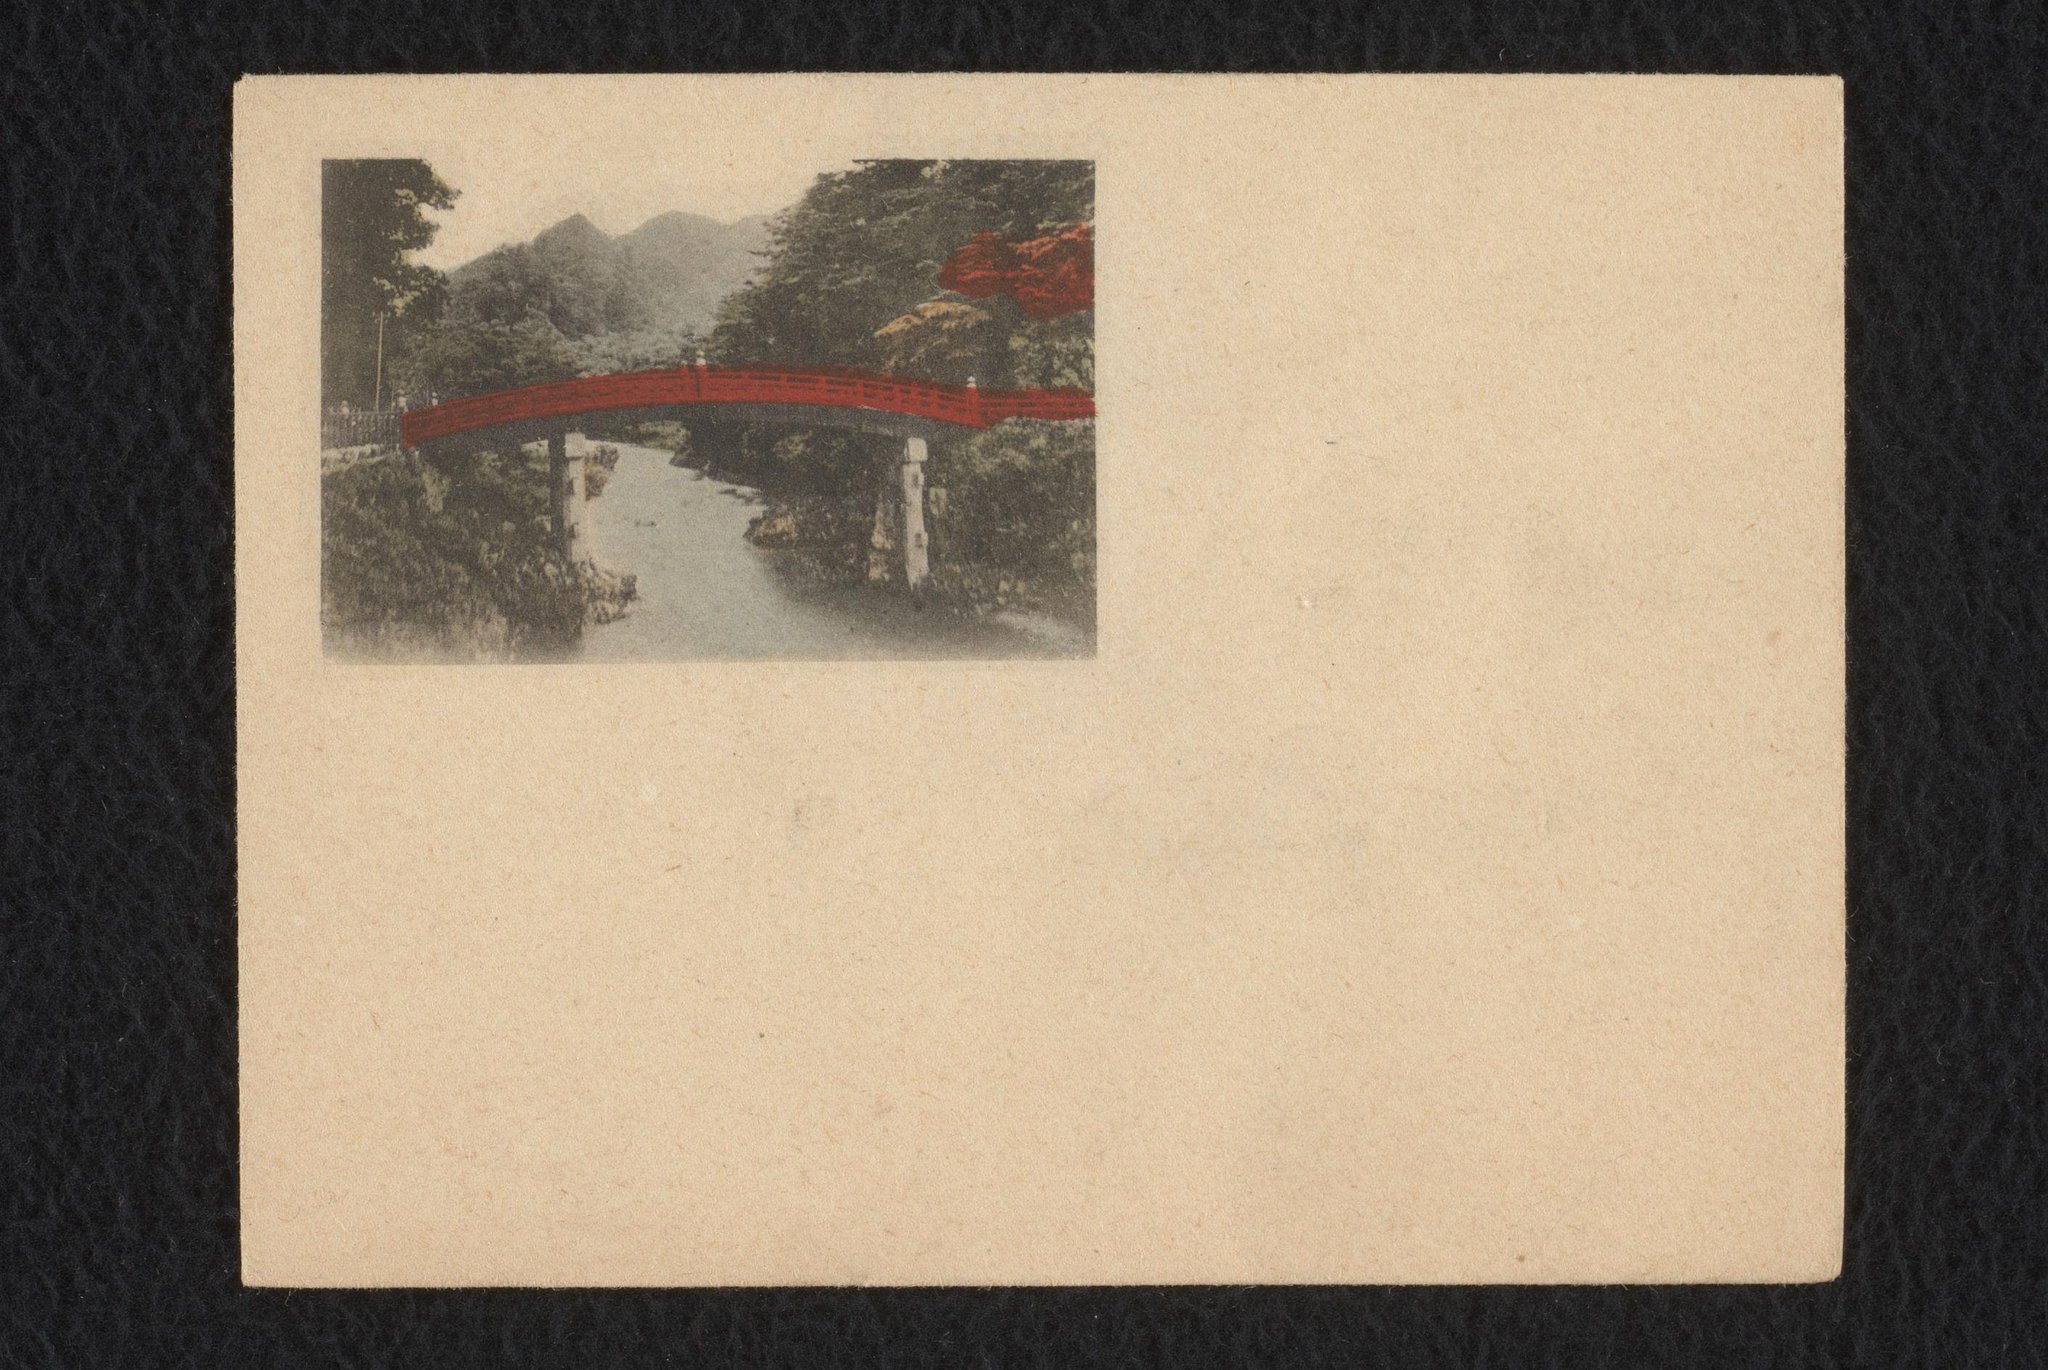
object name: envelope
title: Brug nabij Nikko, Japan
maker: Anonymous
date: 1890-1920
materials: paper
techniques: photograph, lithograph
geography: japan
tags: bridge